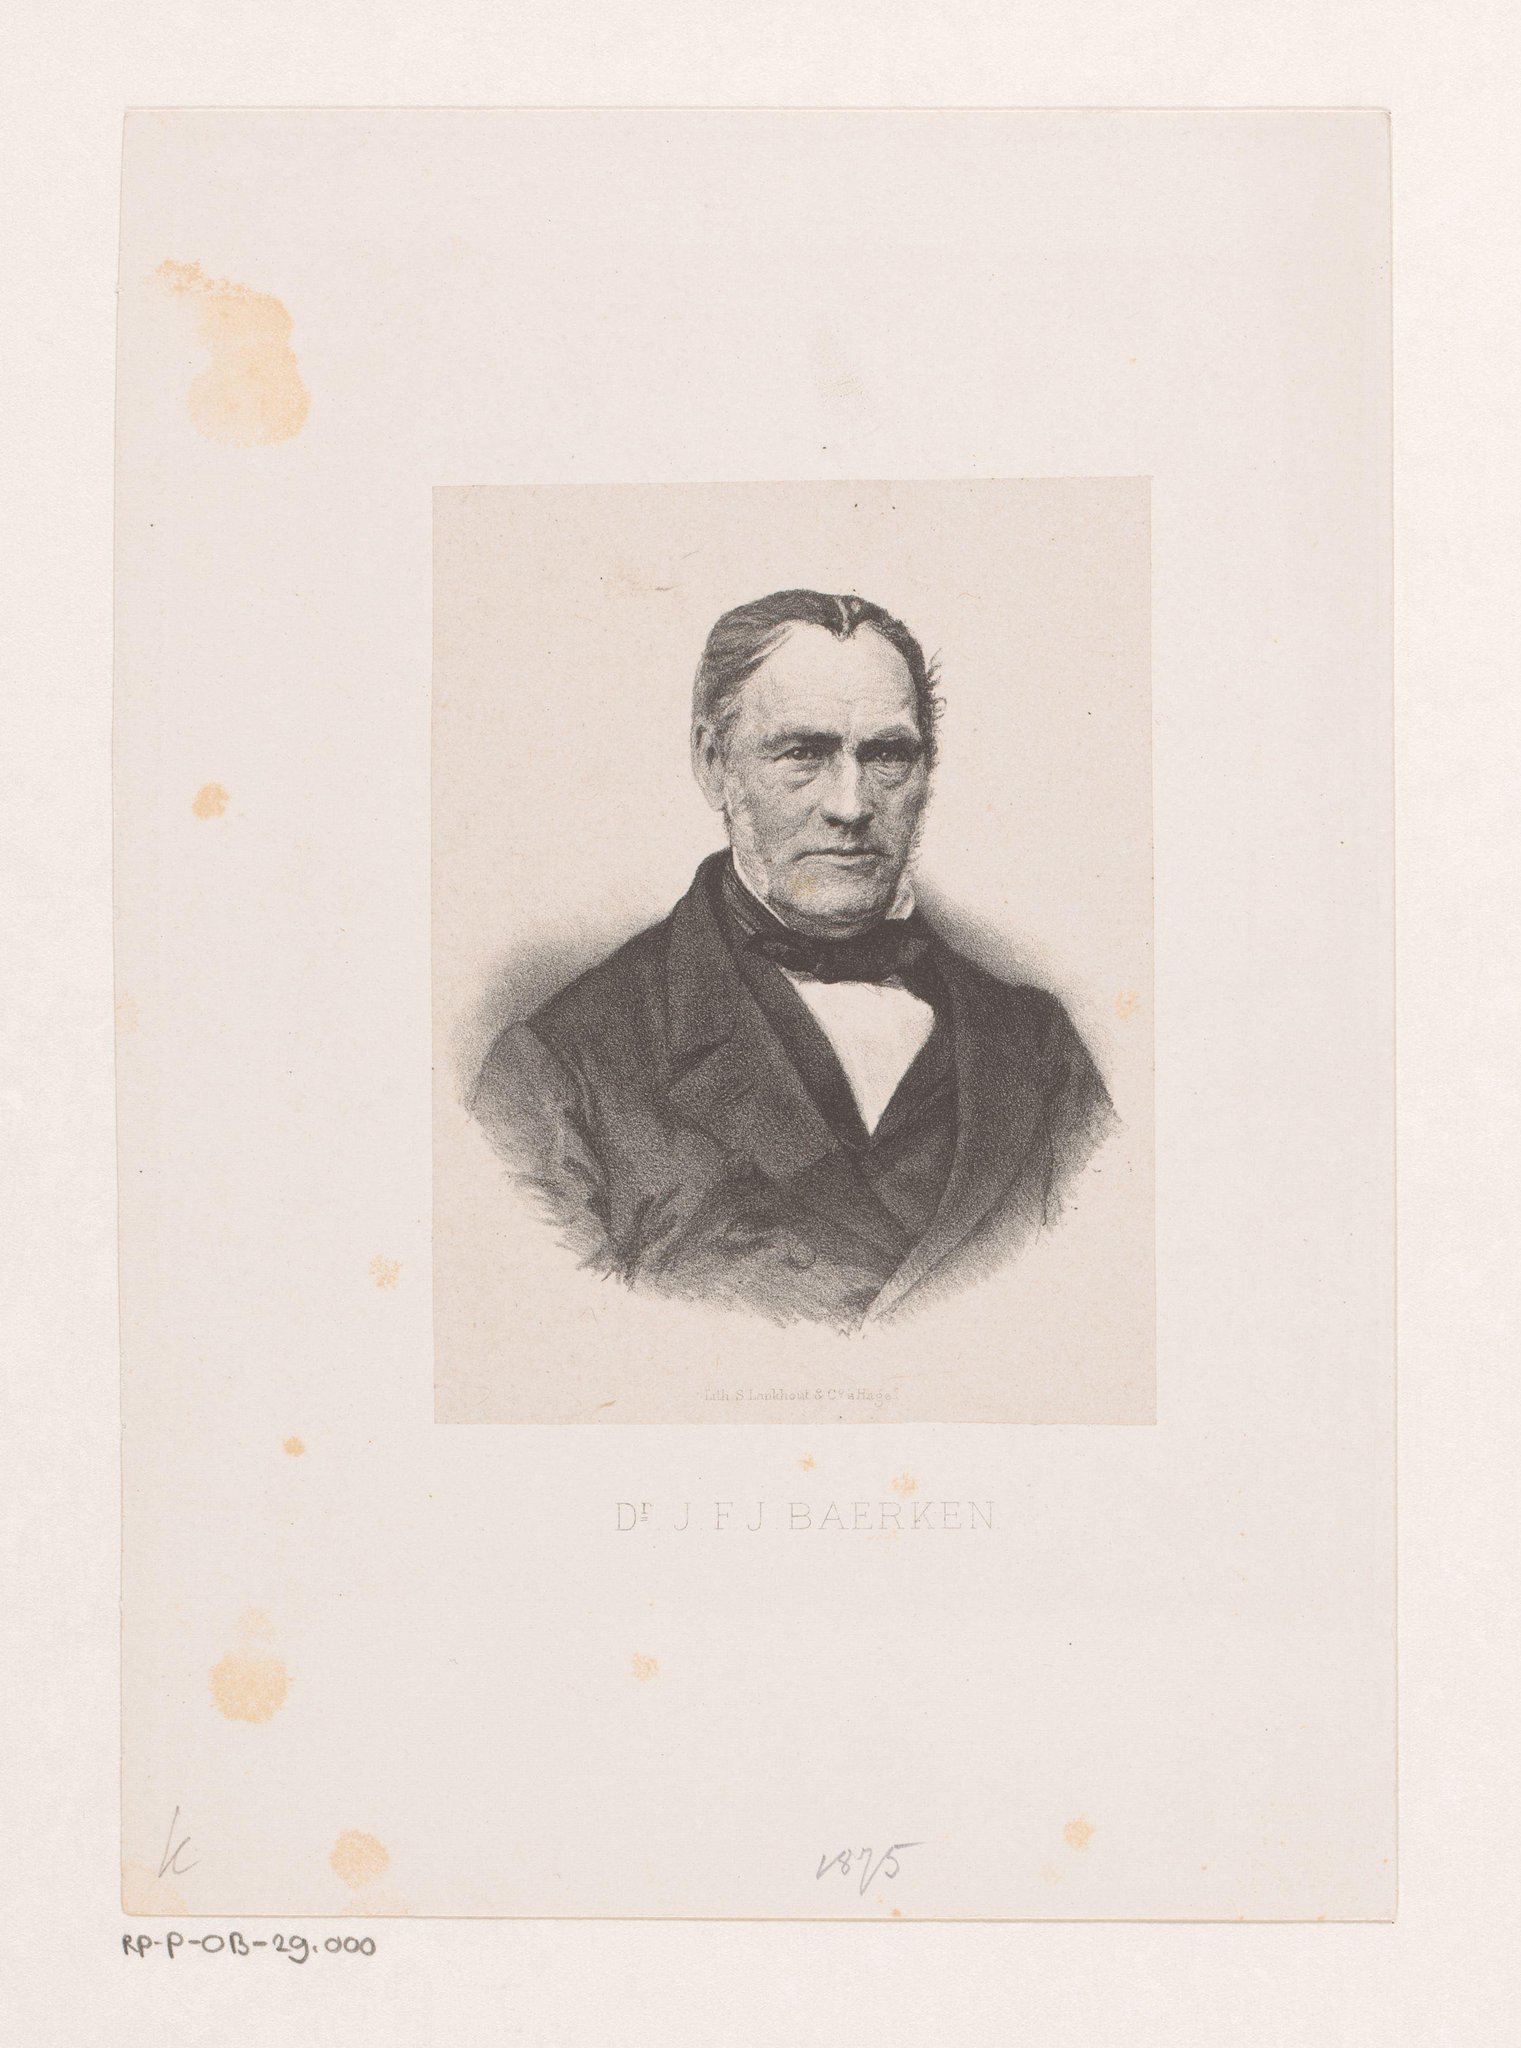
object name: print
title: Portret van J.F.J. Baerken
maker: Anonymous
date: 1875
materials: paper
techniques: lithograph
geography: the hague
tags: historical persons (+ (full) bust portrait)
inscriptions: collector's mark: Lugt 2228